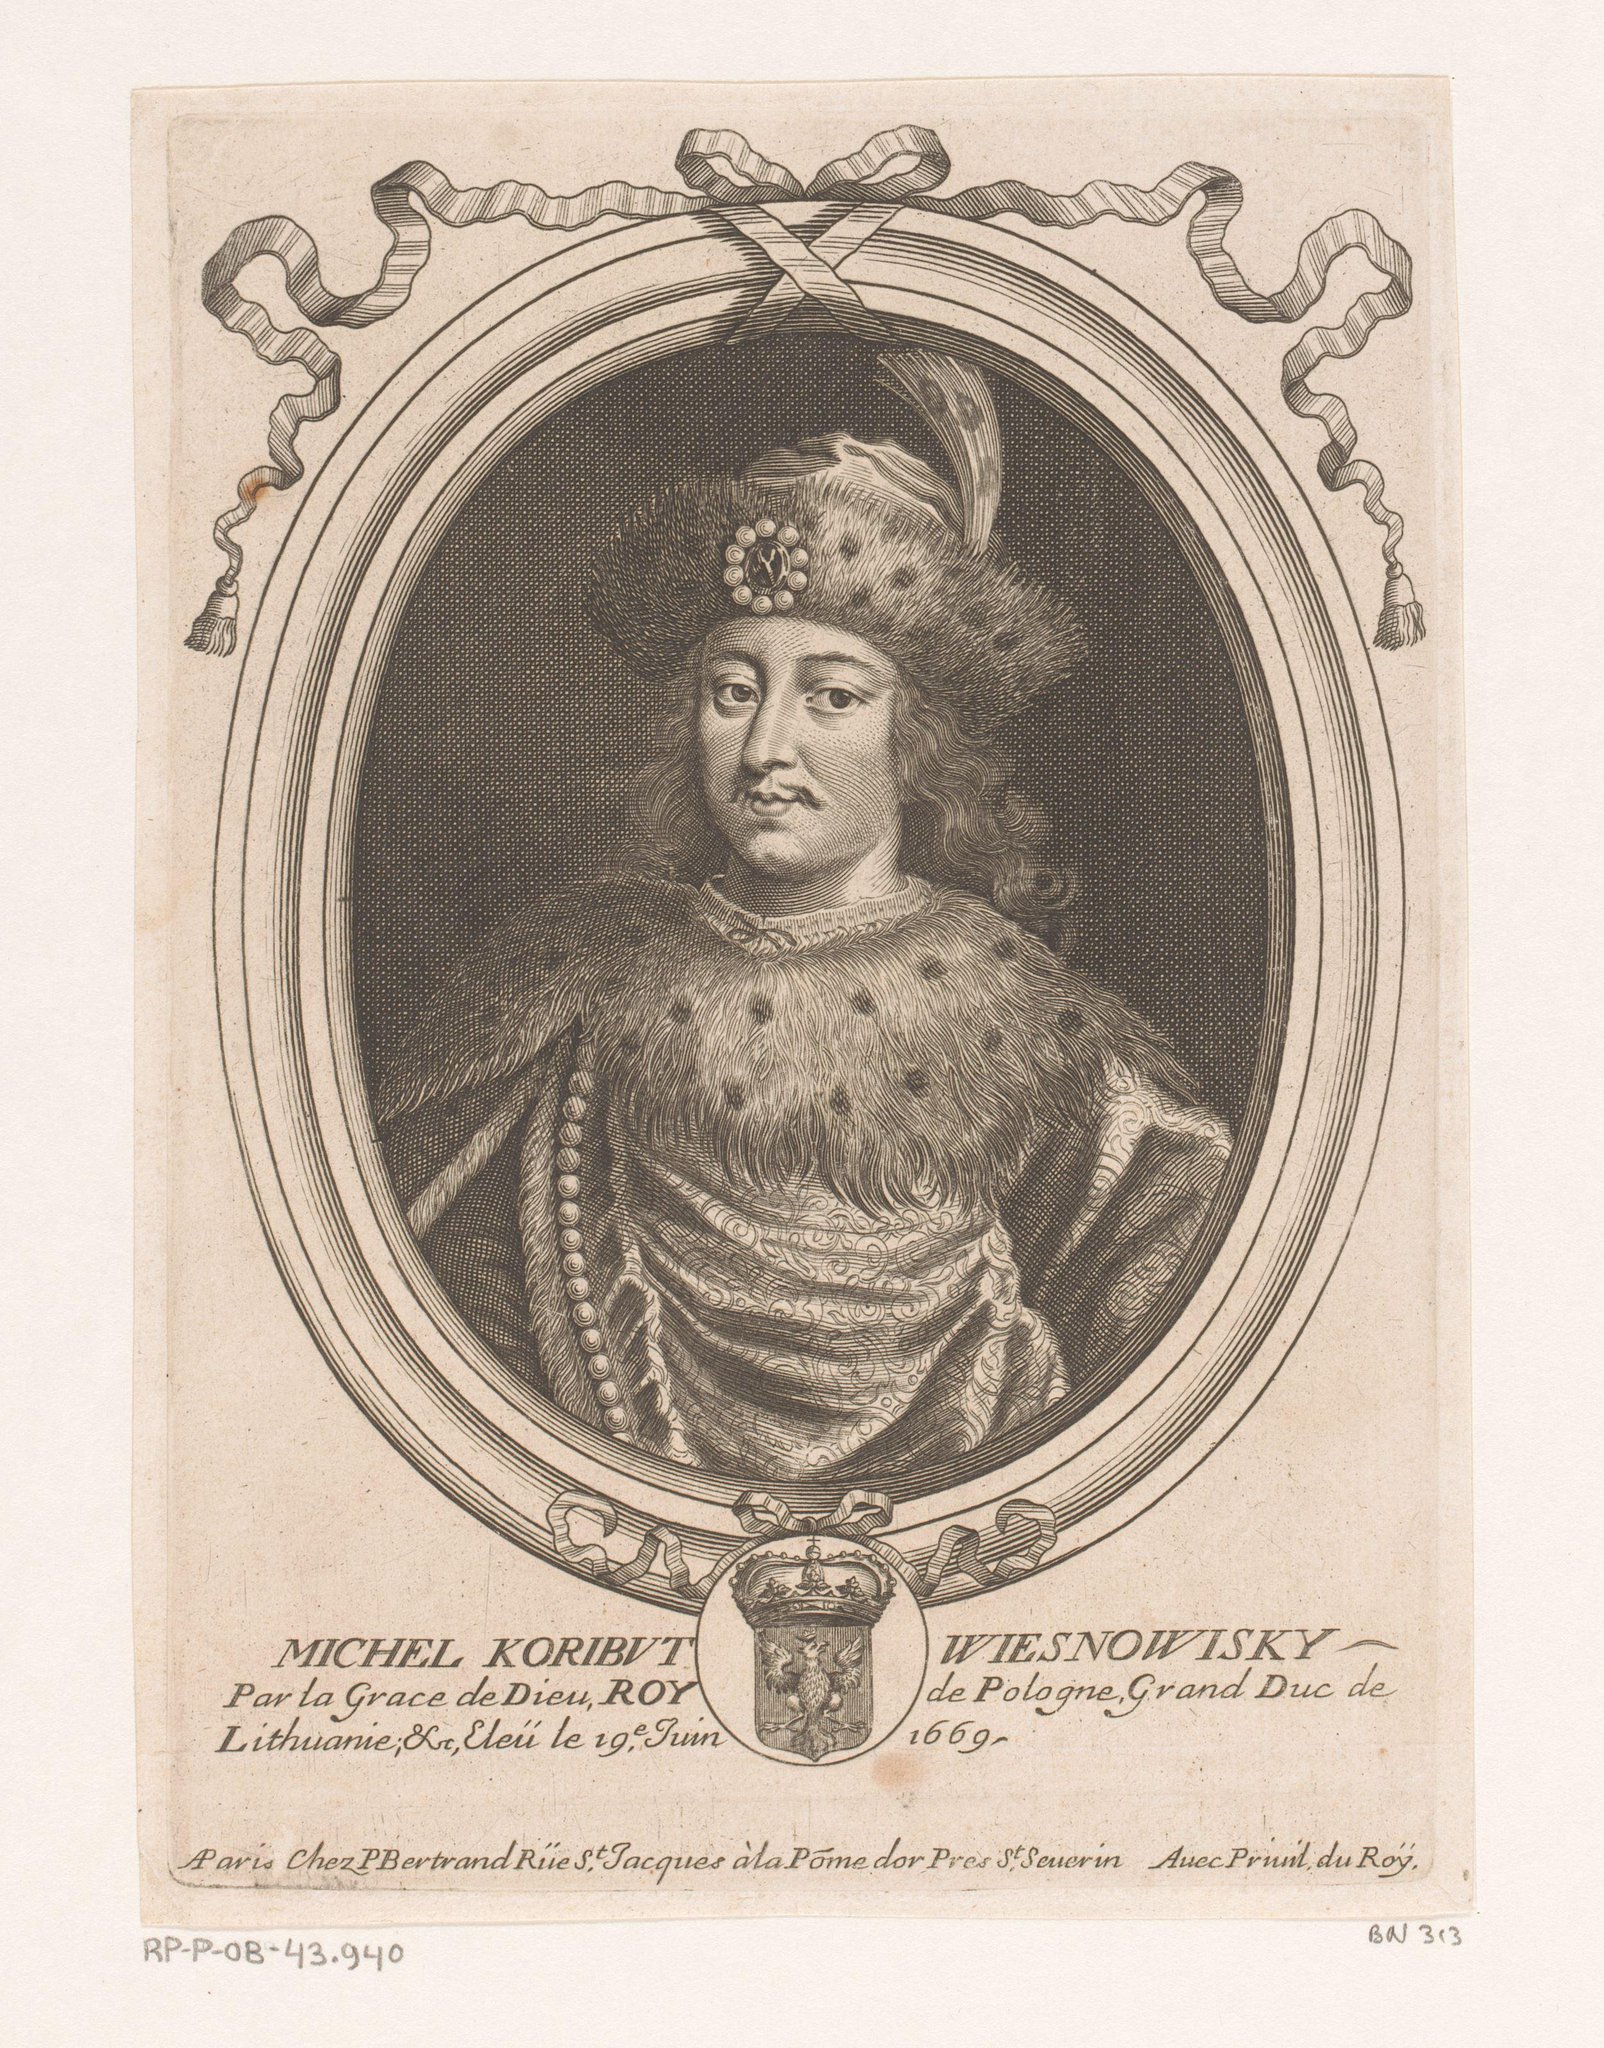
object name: print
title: Portrette van prominente figuren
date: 1669-1678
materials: paper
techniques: engraving, etching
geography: france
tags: historical persons, king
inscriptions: collector's mark: Lugt 2228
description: Maakt deel uit van een grootschalige serie met portretten van prominente figuren. Binnen de serie bevindt zich een sectie getiteld 'Les Augustes Représentations De tous les Roys De France depuis Pharamond Iusqu'à Louys XIIII'. De serie werd respectievelijk uitgegeven door Pierre Bertrand, door zijn weduwe en door De Larmessin zelf.